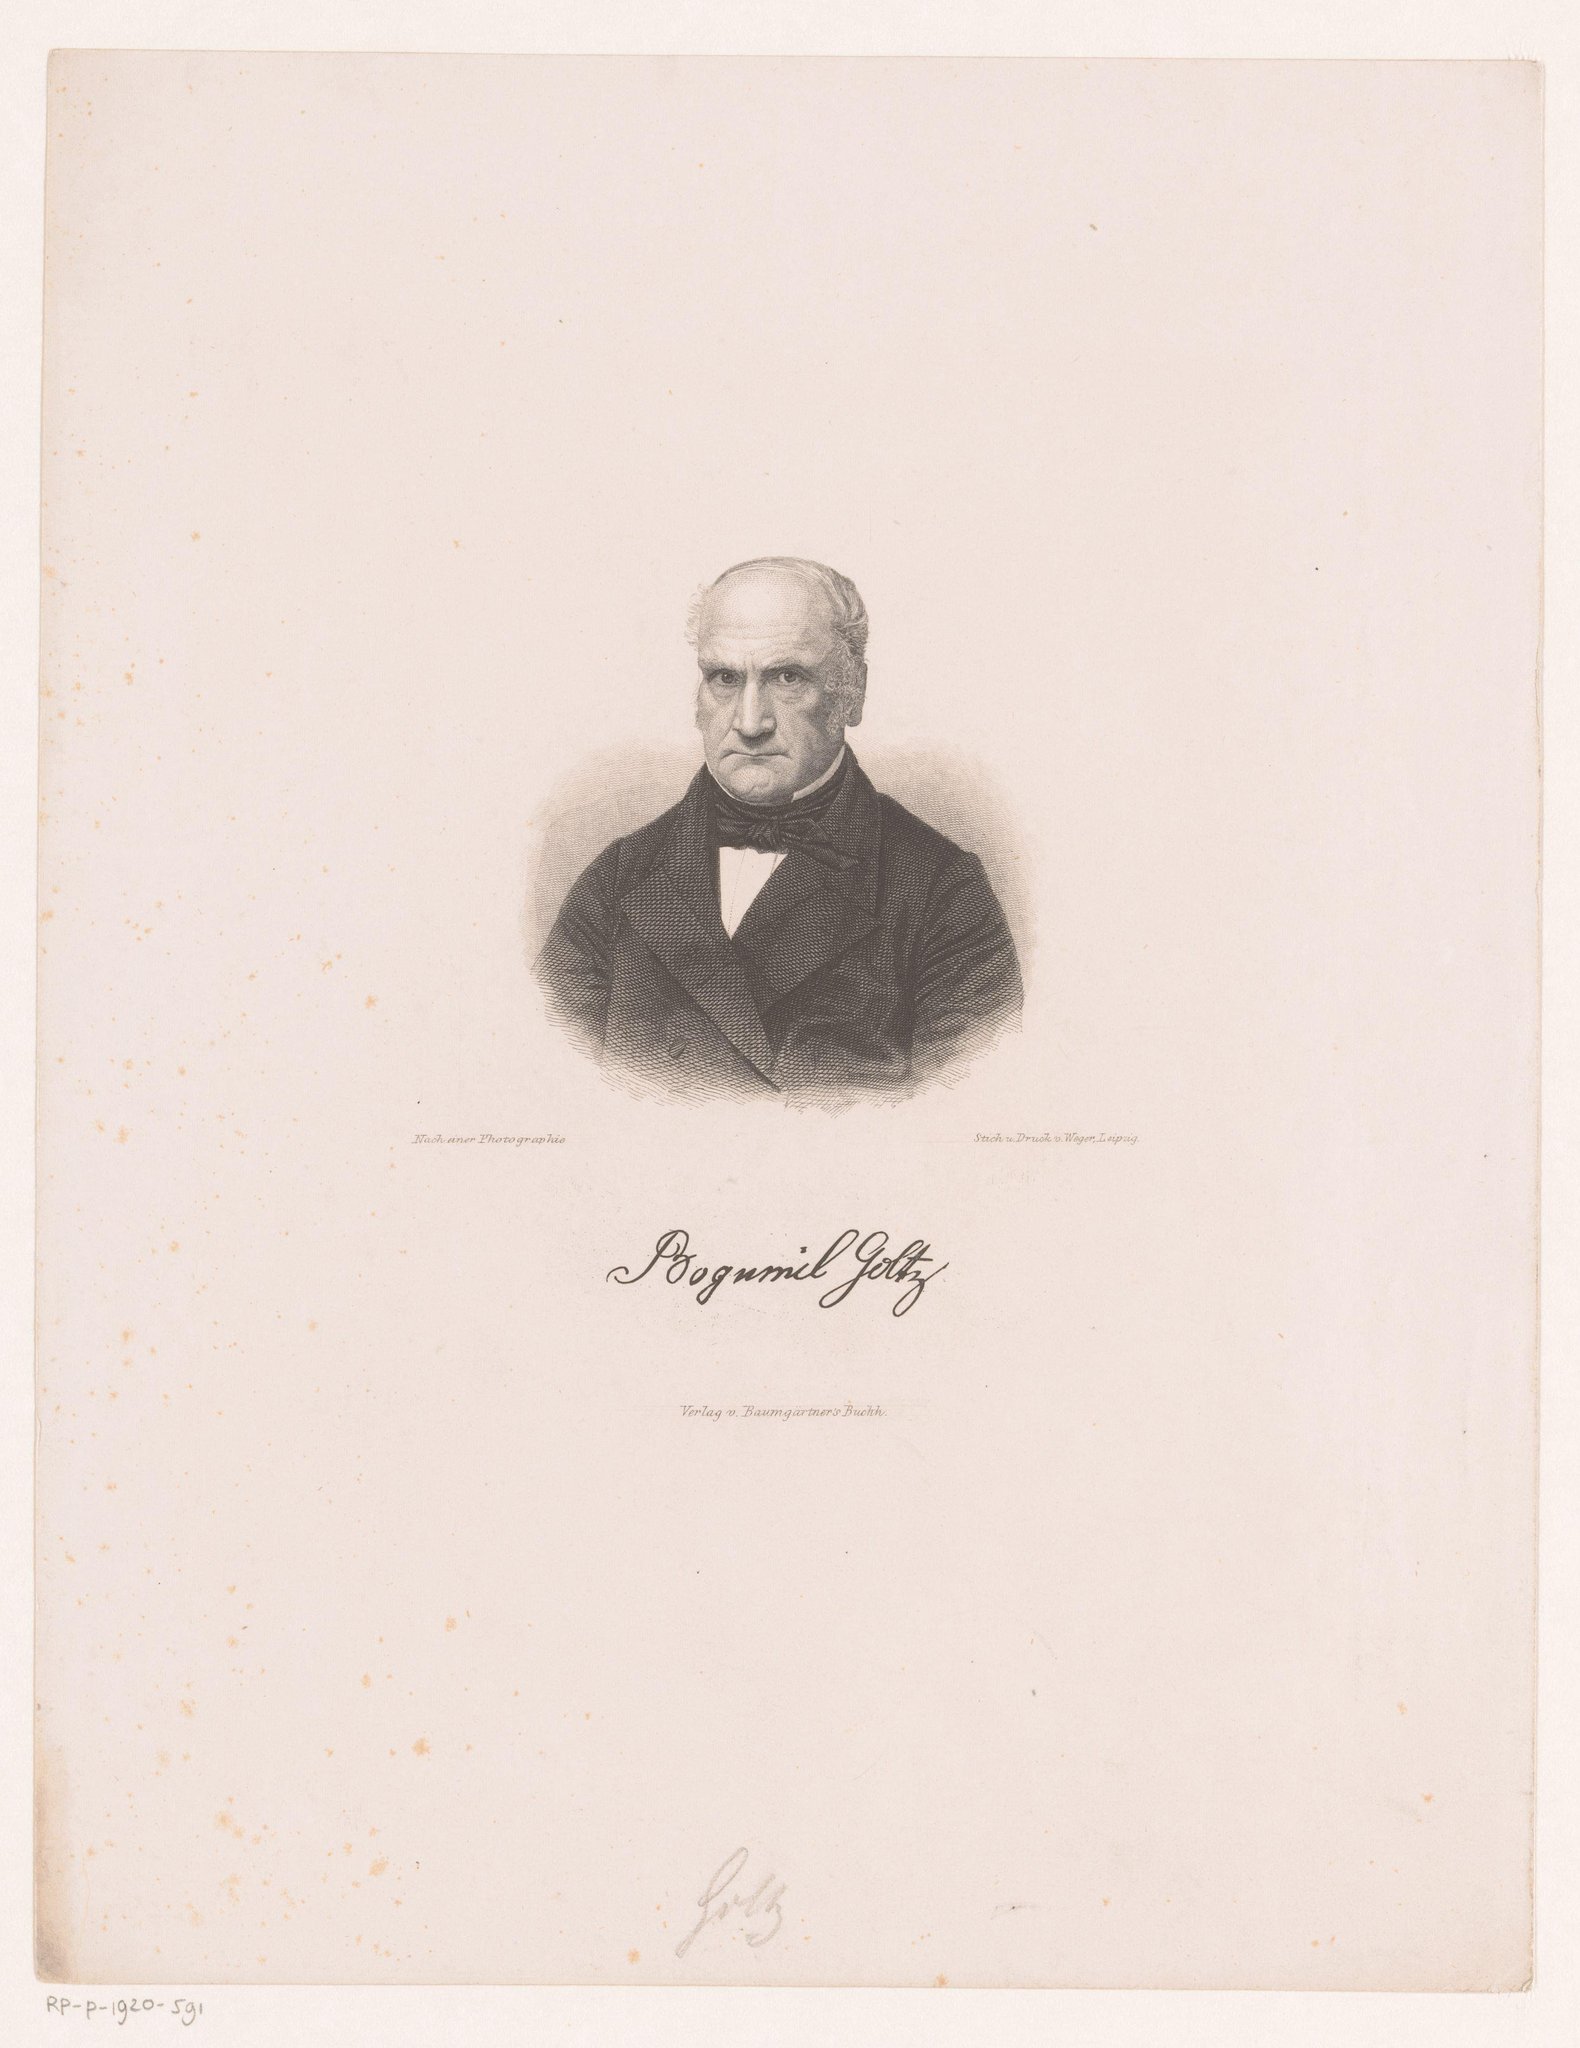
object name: print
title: Portret van Bogumil von der Goltz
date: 1849-1892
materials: paper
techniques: engraving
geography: leipzig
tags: historical persons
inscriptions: collector's mark: Lugt 2228